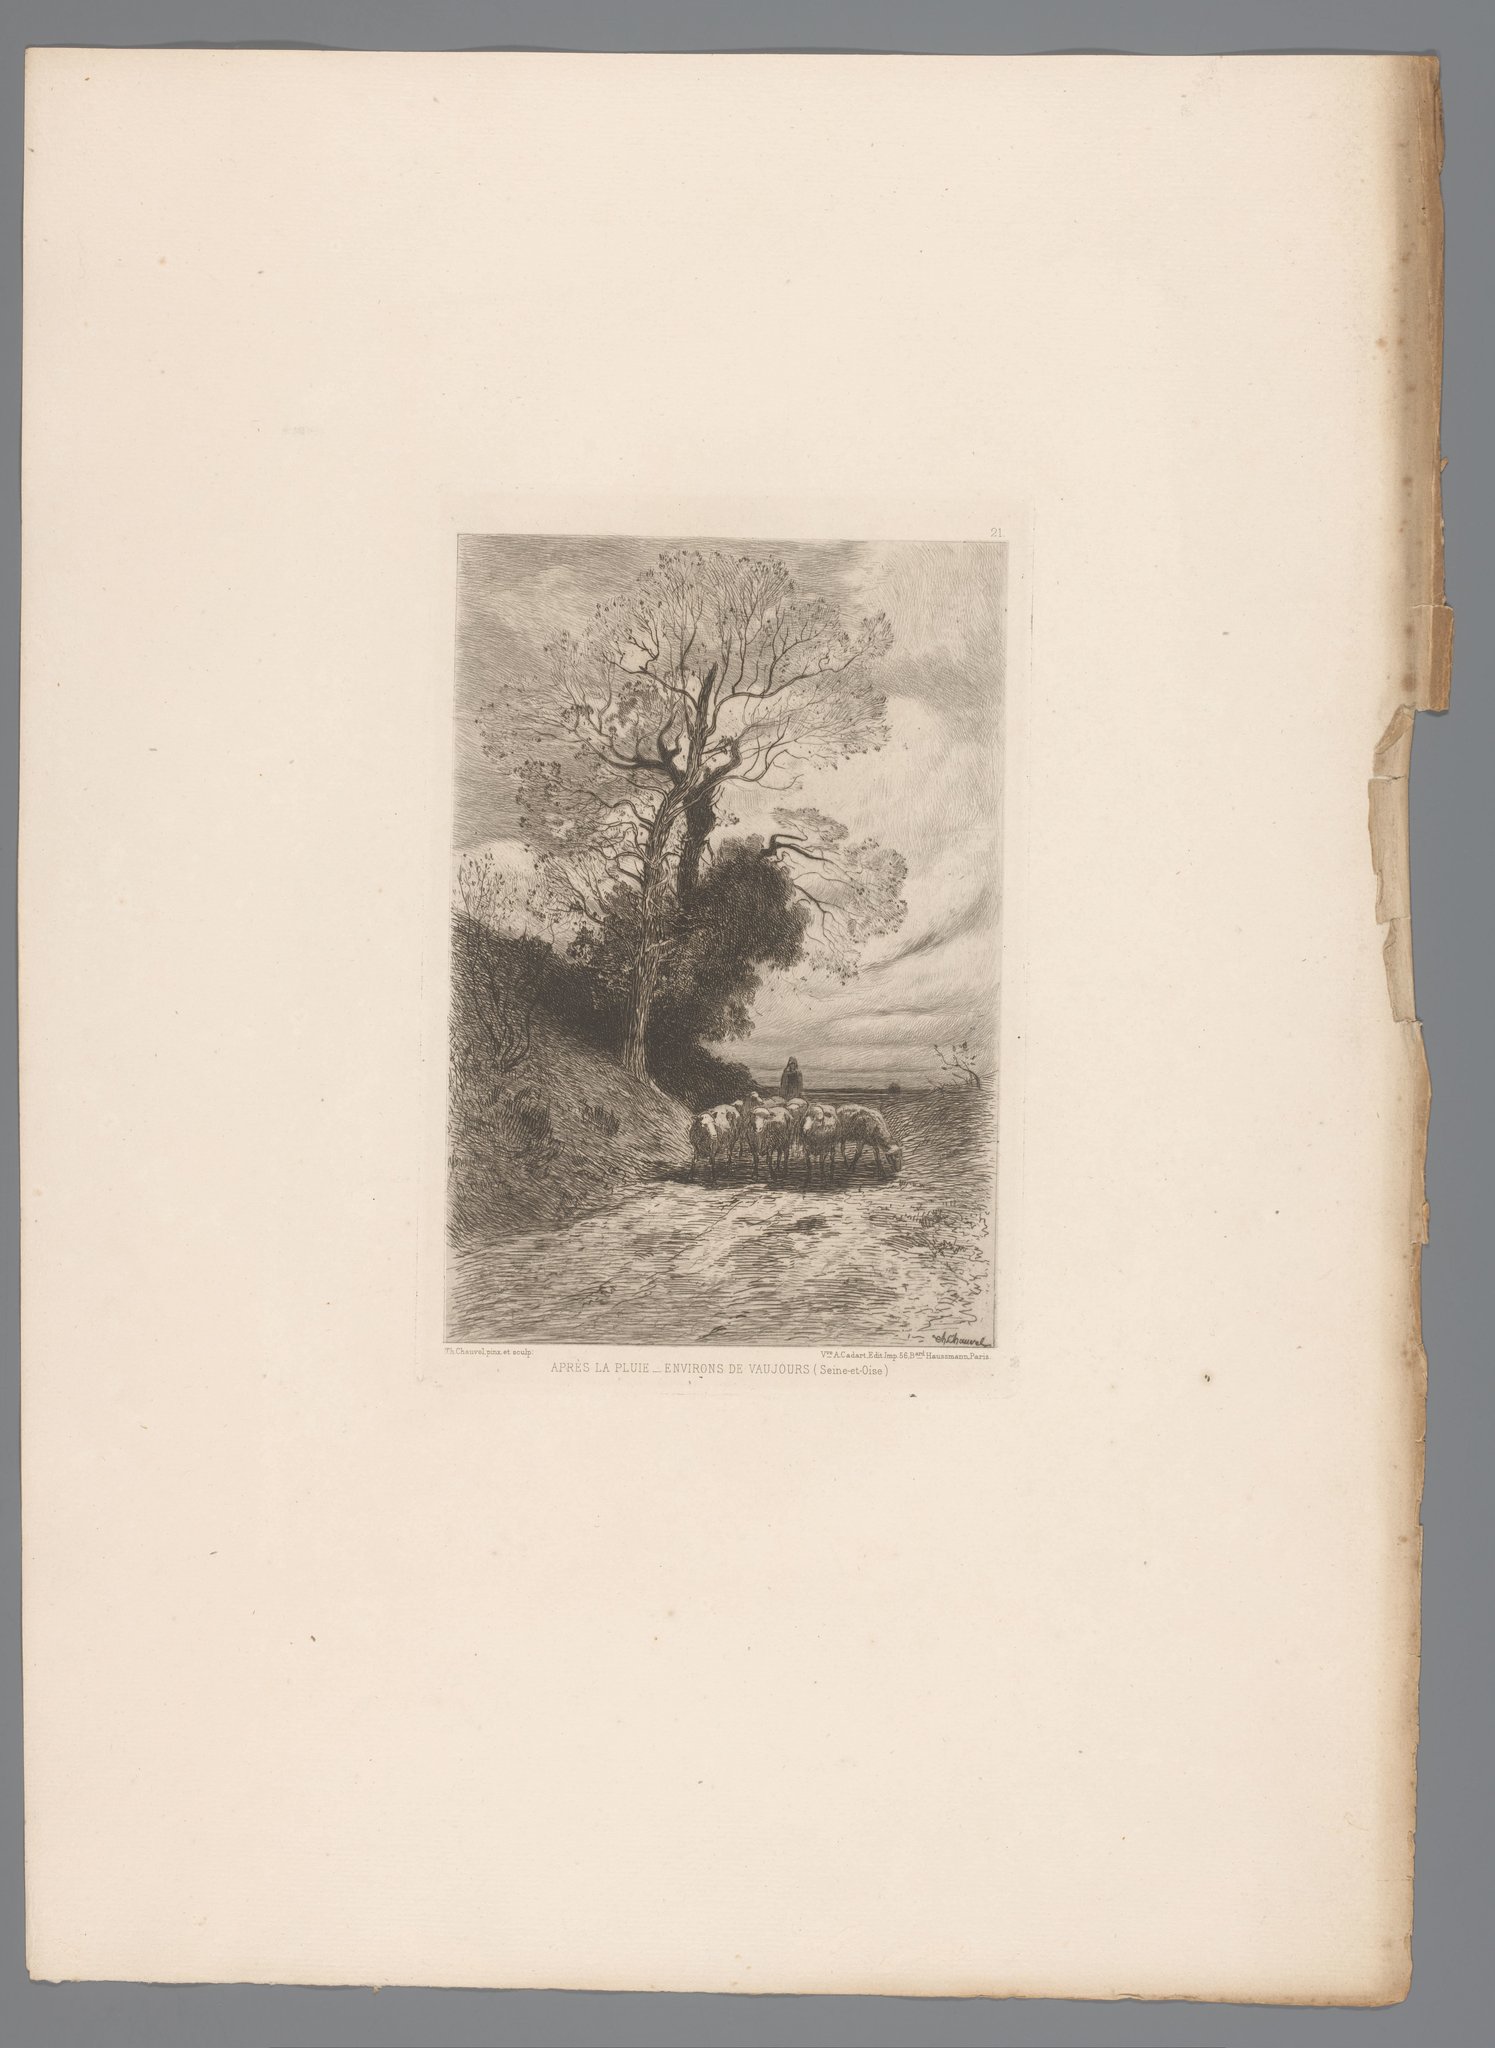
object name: print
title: Herder met schaapskudde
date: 1876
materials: paper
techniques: drypoint, etching, intaglio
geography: paris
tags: sheep, herd, flock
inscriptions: collector's mark: Lugt 2228, collector's mark: Lugt 2760, collector's mark: ‘AFE v S’, watermark